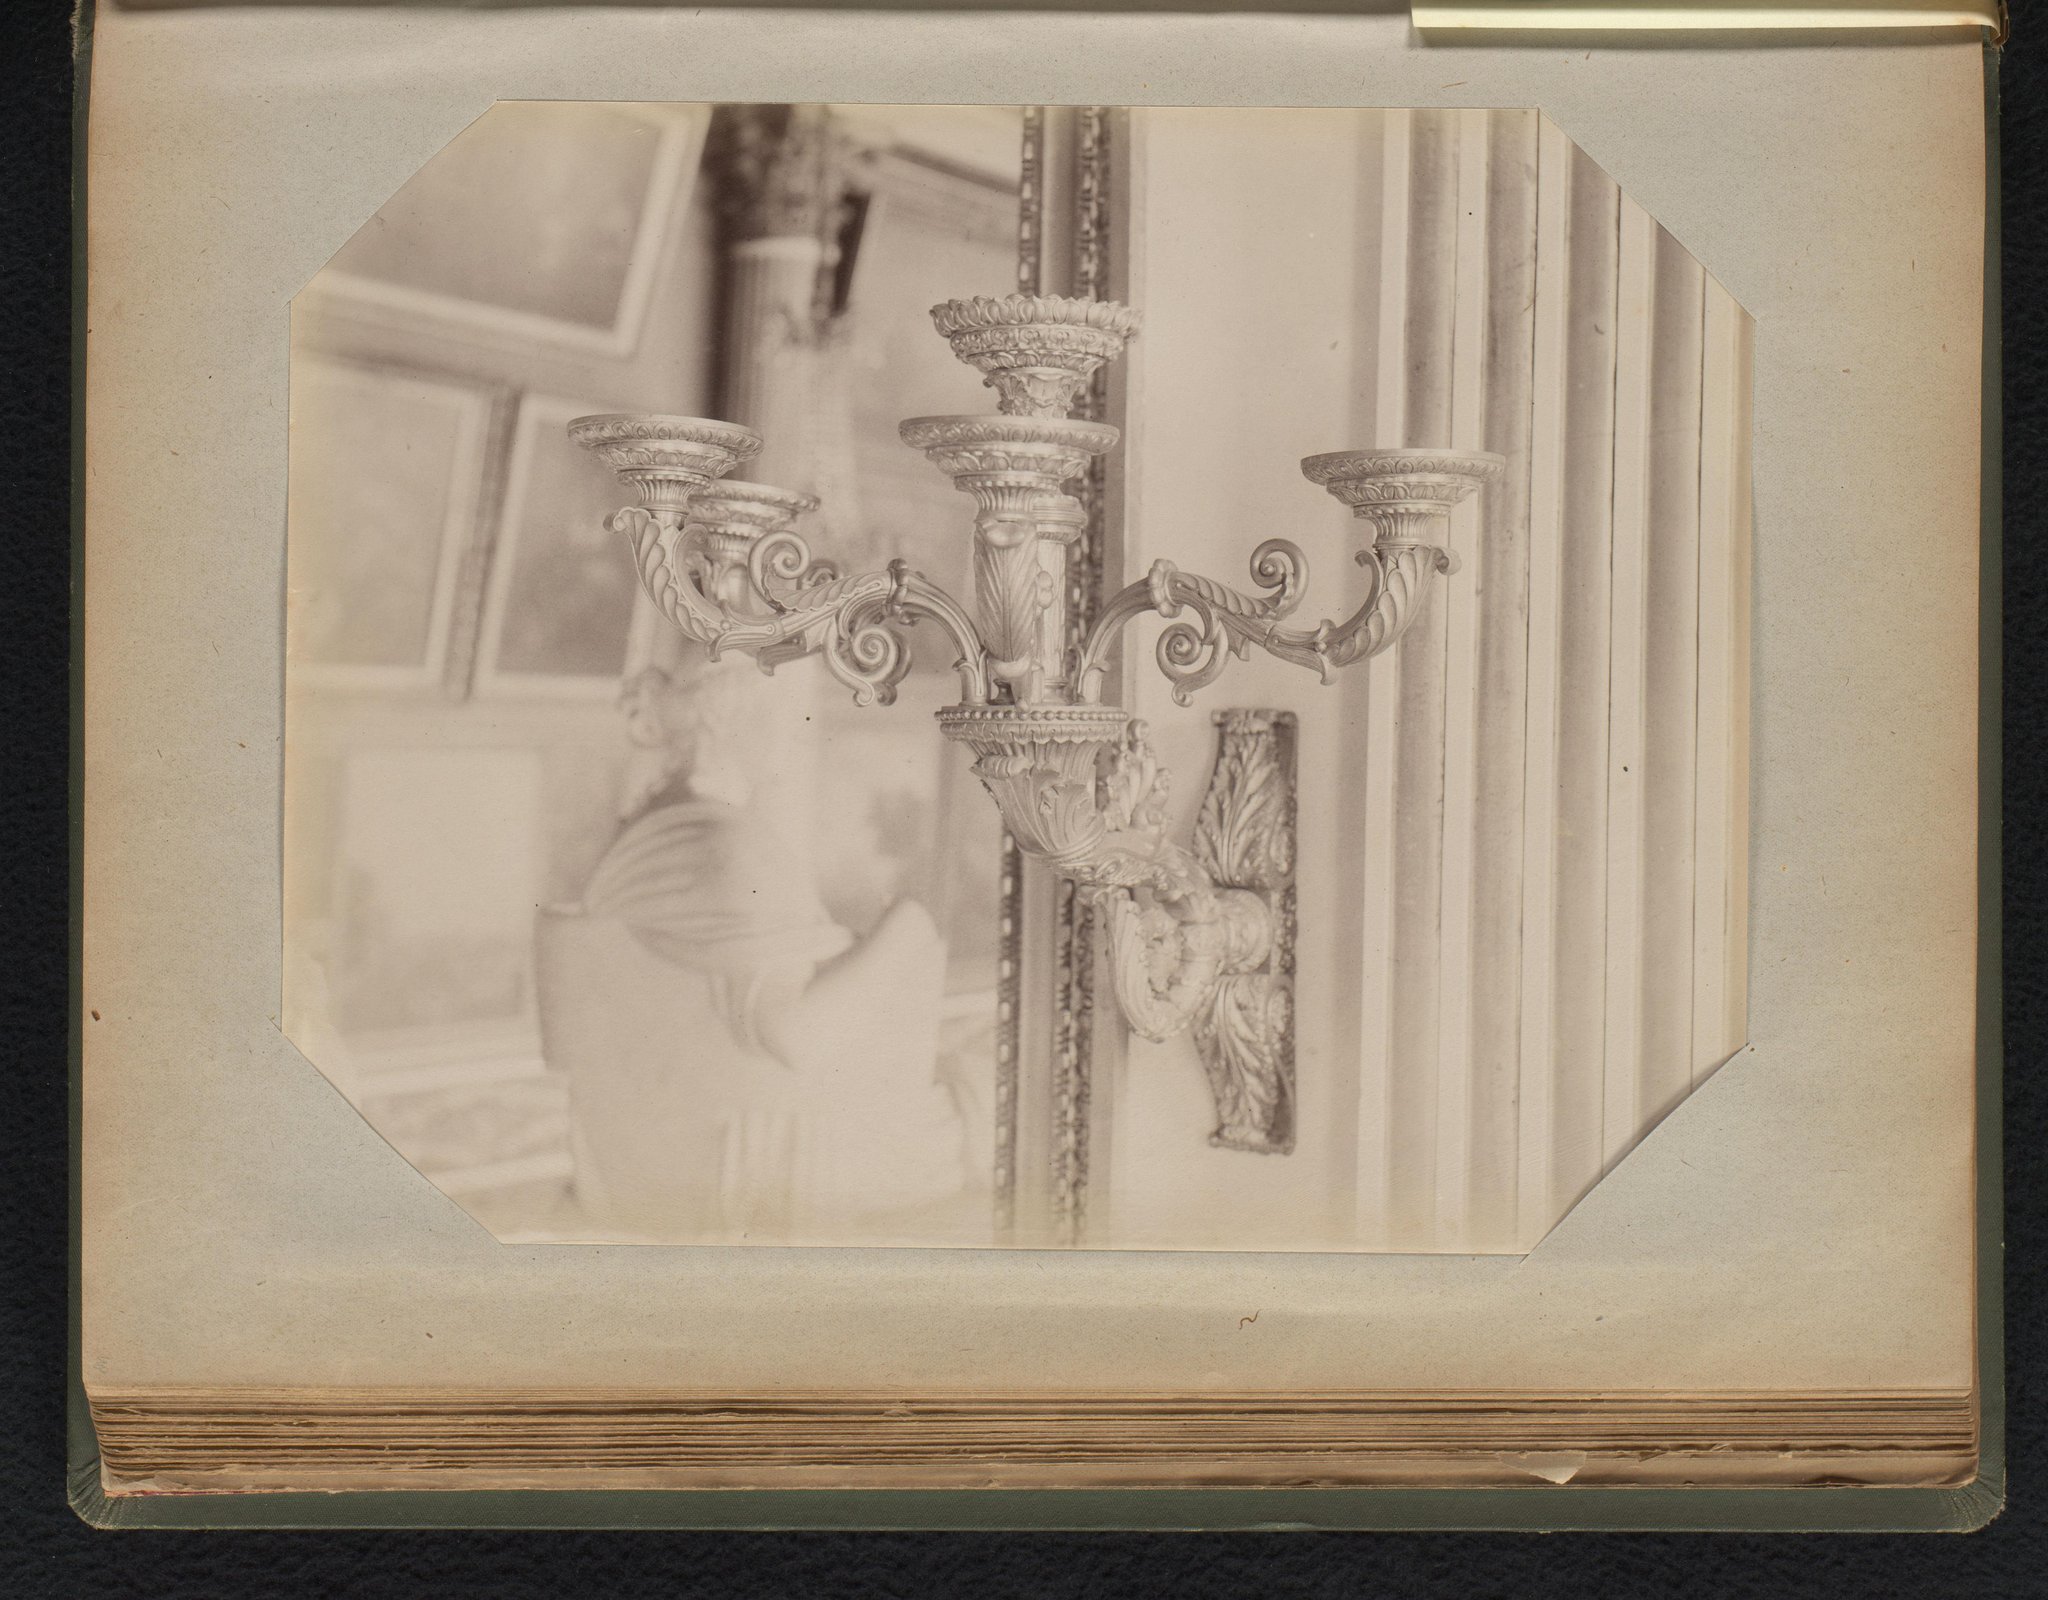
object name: photograph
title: Bronzen vijfarmige muurkandelaar met bewerkte armen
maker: Anonymous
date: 1860-1900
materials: paper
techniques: albumen print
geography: france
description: Onderdeel van een serie met betrekking tot het interieur van het paleis van Versailles met kroonluchters, deuren, portalen en meubelstukken.